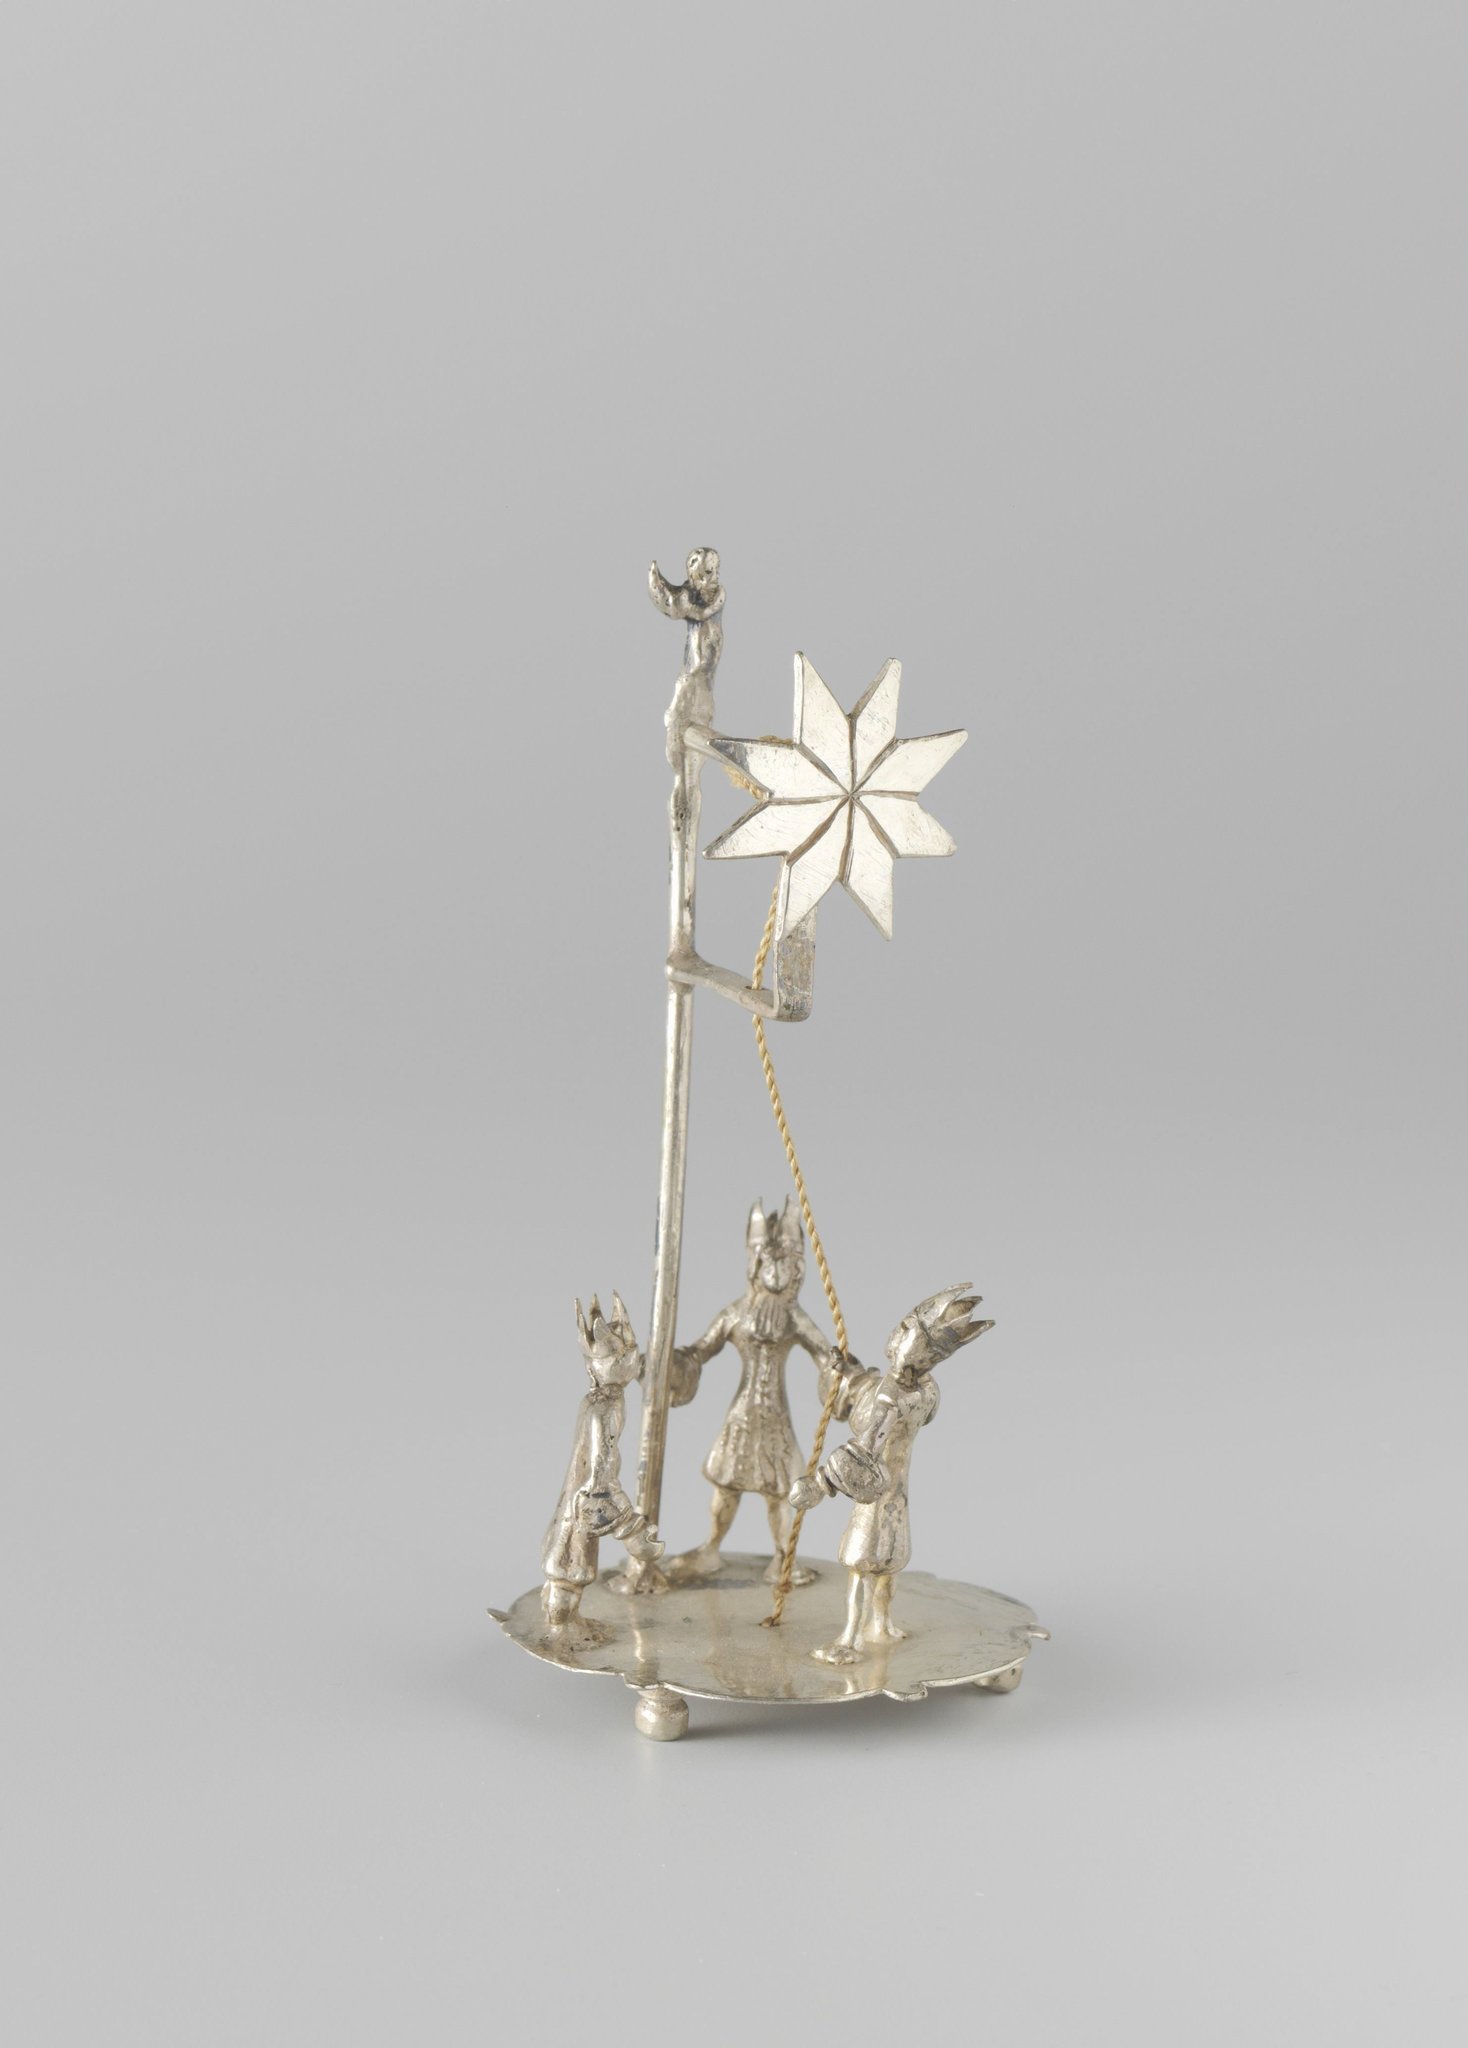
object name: miniature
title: Driekoningen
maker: Anonymous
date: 1700-1750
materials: silver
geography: netherlands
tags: twelfth night, usually falling on the eve of january 6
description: Driekoningengroep op een zeslobbige plaat. De plaat staat op drie bolpoten. De groep bestaat uit drie figuren met kronen op het hoofd. Een van de figuren houdt een paal vast, waaraan een achtpuntige ster is bevestigd. De ster kan worden rondgedraaid door een koord dat een van de andere figuren vasthoudt. Bovenop de paal zit een putto. In het beeld zijn de letters C A B gekrast. Het beeld is niet gemerkt.